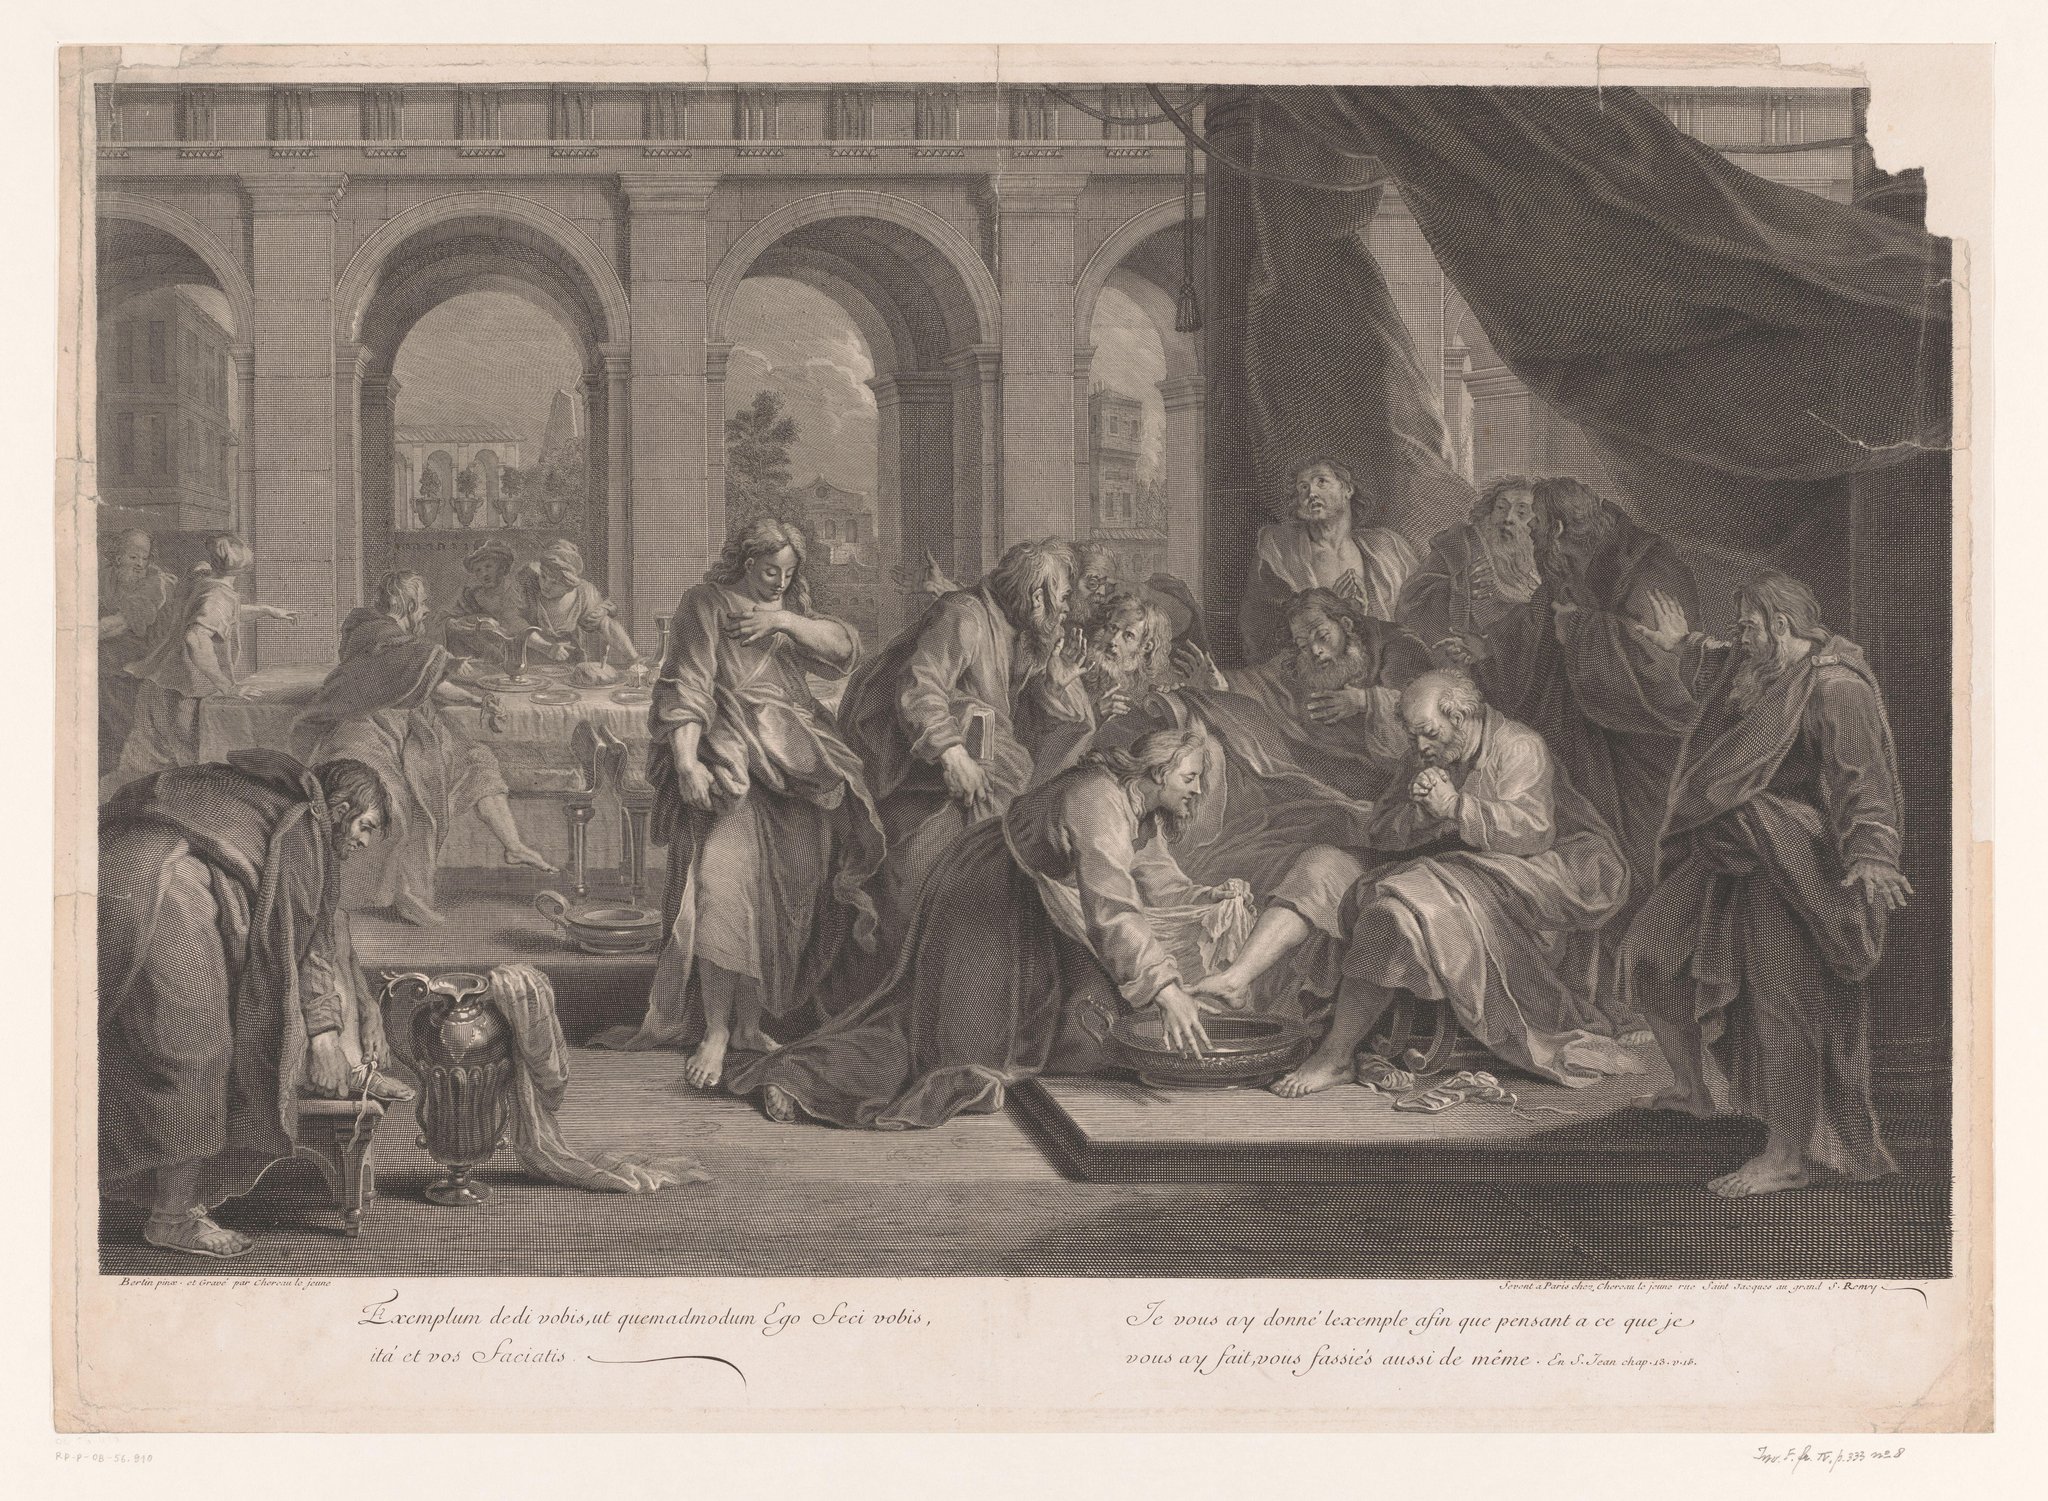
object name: print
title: Voetwassing van Petrus door Christus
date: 1698-1776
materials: paper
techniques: engraving, etching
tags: christ washes peter's feet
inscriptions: collector's mark: Lugt 2228